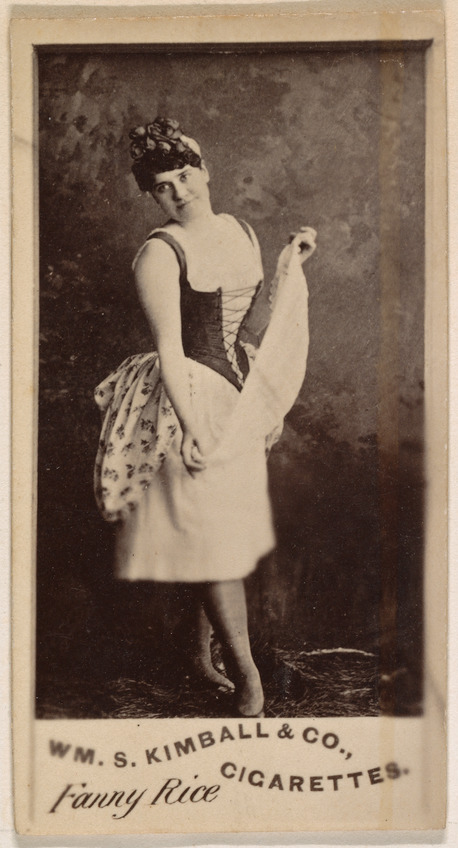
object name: photograph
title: Fanny Rice, from the Actresses series (N203) issued by Wm. S. Kimball & Co.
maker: william s. kimball & company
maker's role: publisher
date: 1889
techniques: color lithograph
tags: portraits,women,actresses